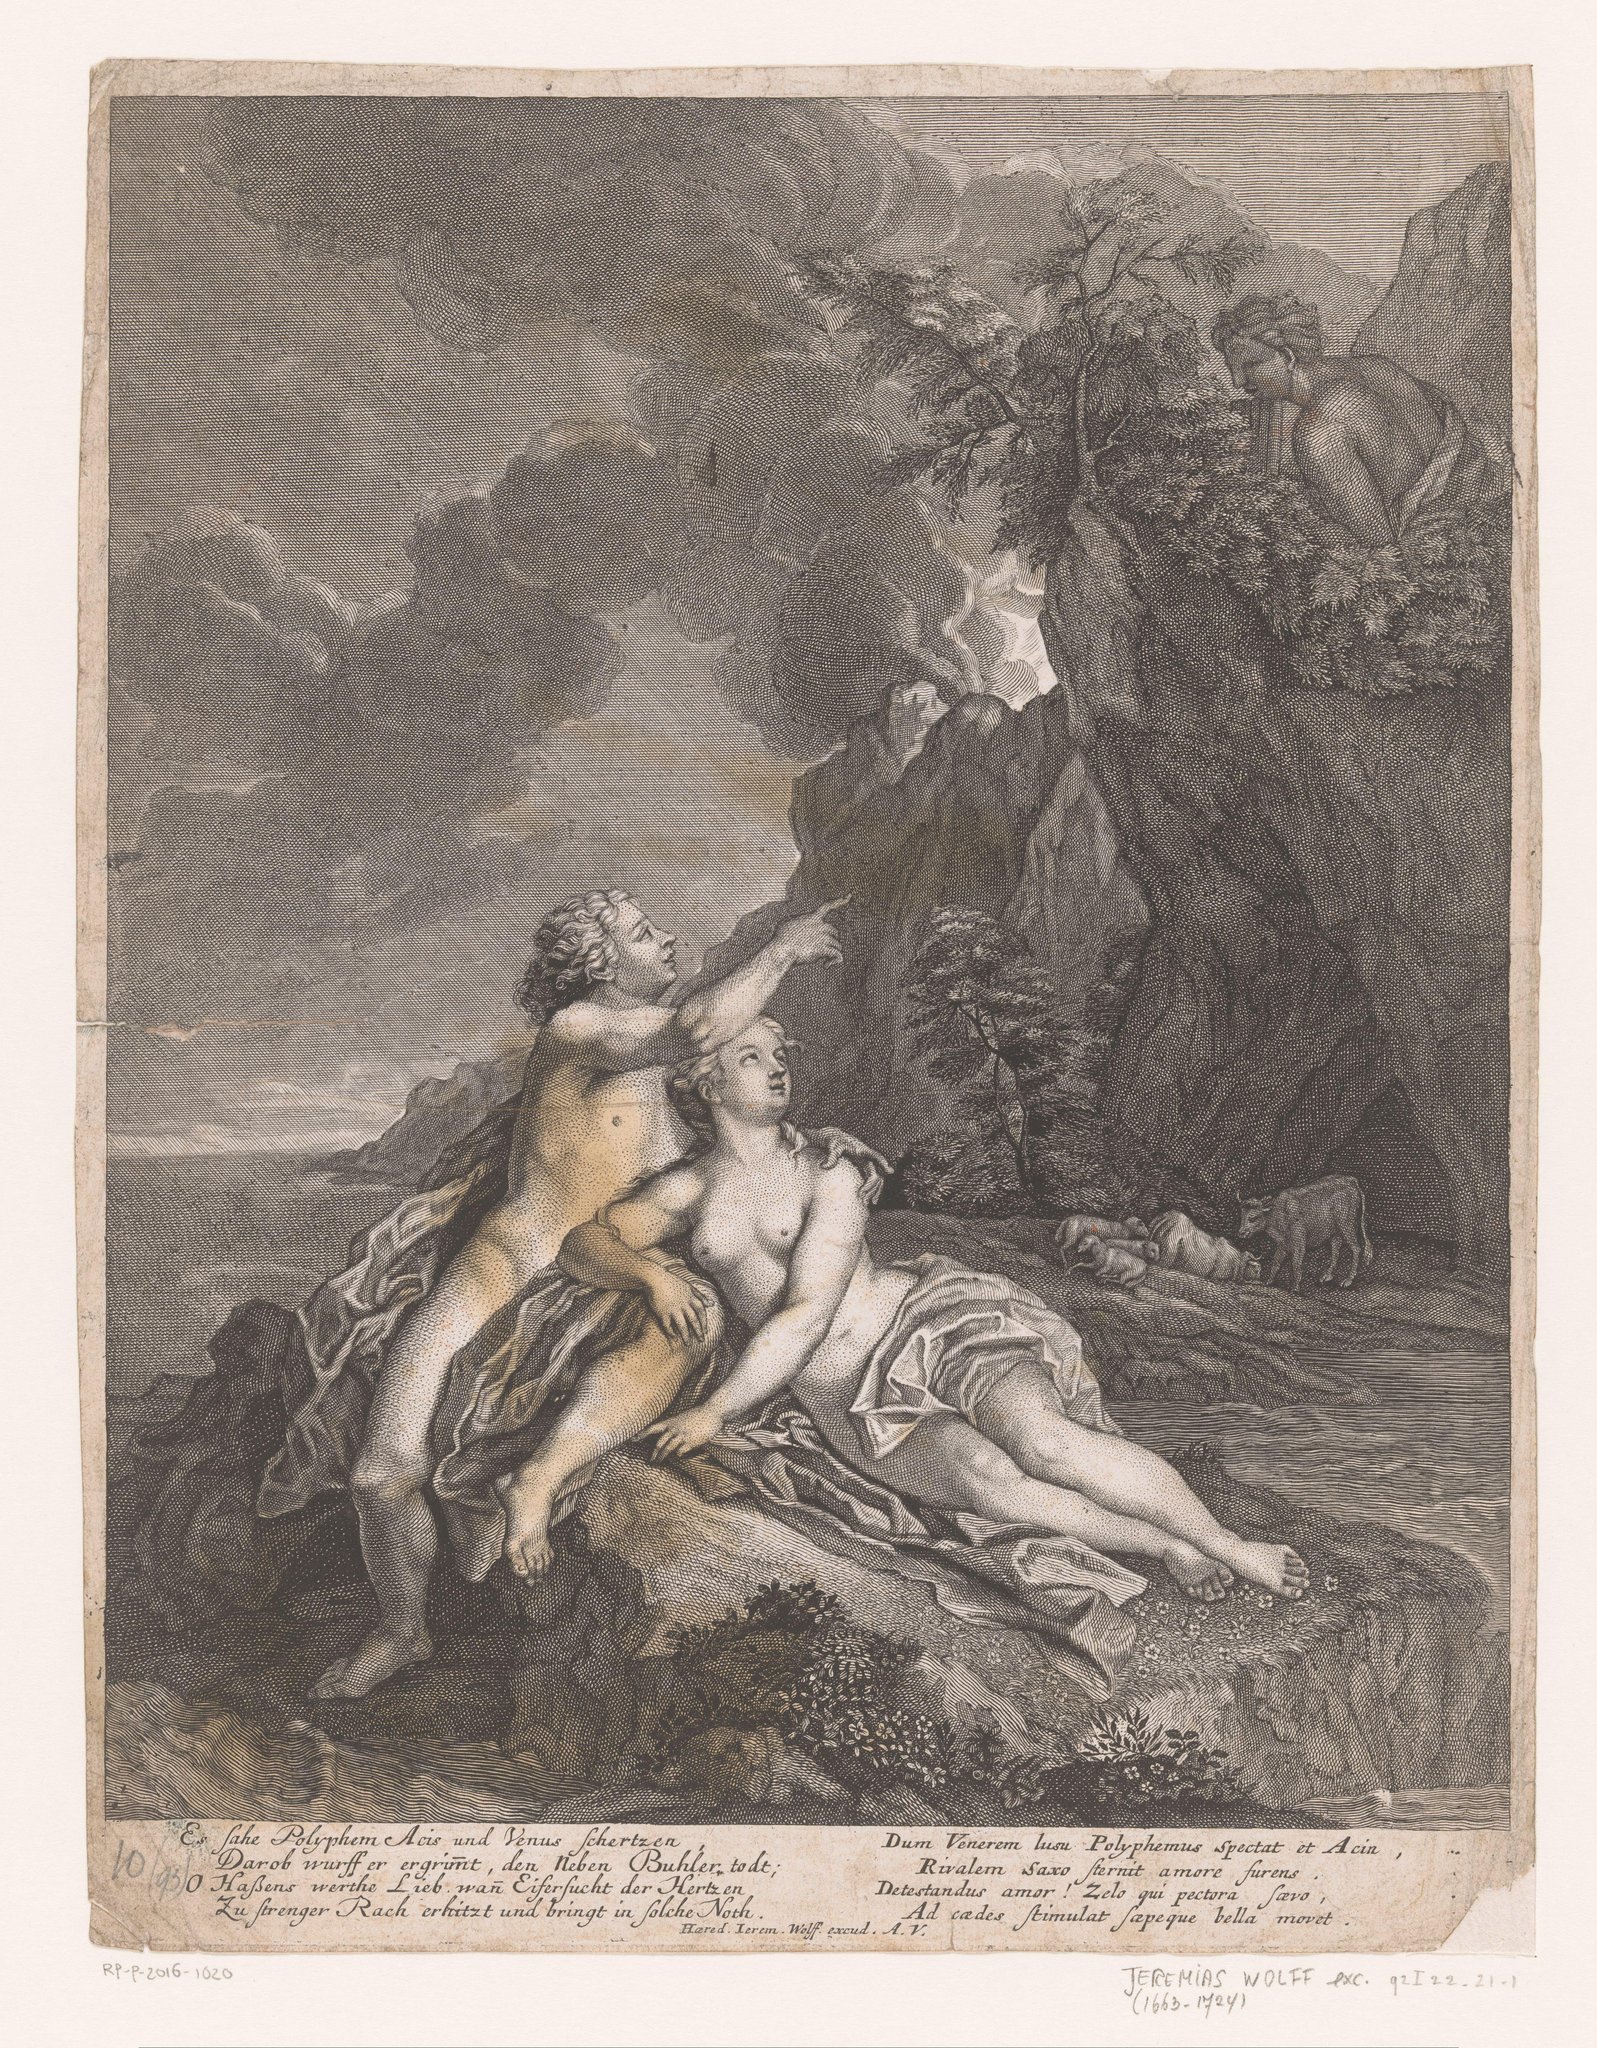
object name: print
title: Polyphemus ontdekt Galatea in de armen van Acis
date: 1673-1724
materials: paper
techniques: engraving, etching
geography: augsburg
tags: polyphemus, the cyclops, beholding acis and galatea, panpipes, herd, flock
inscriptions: collector's mark: Lugt 2228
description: In de ondermarge een kolom Duitse tekst en een kolom Latijnse tekst.